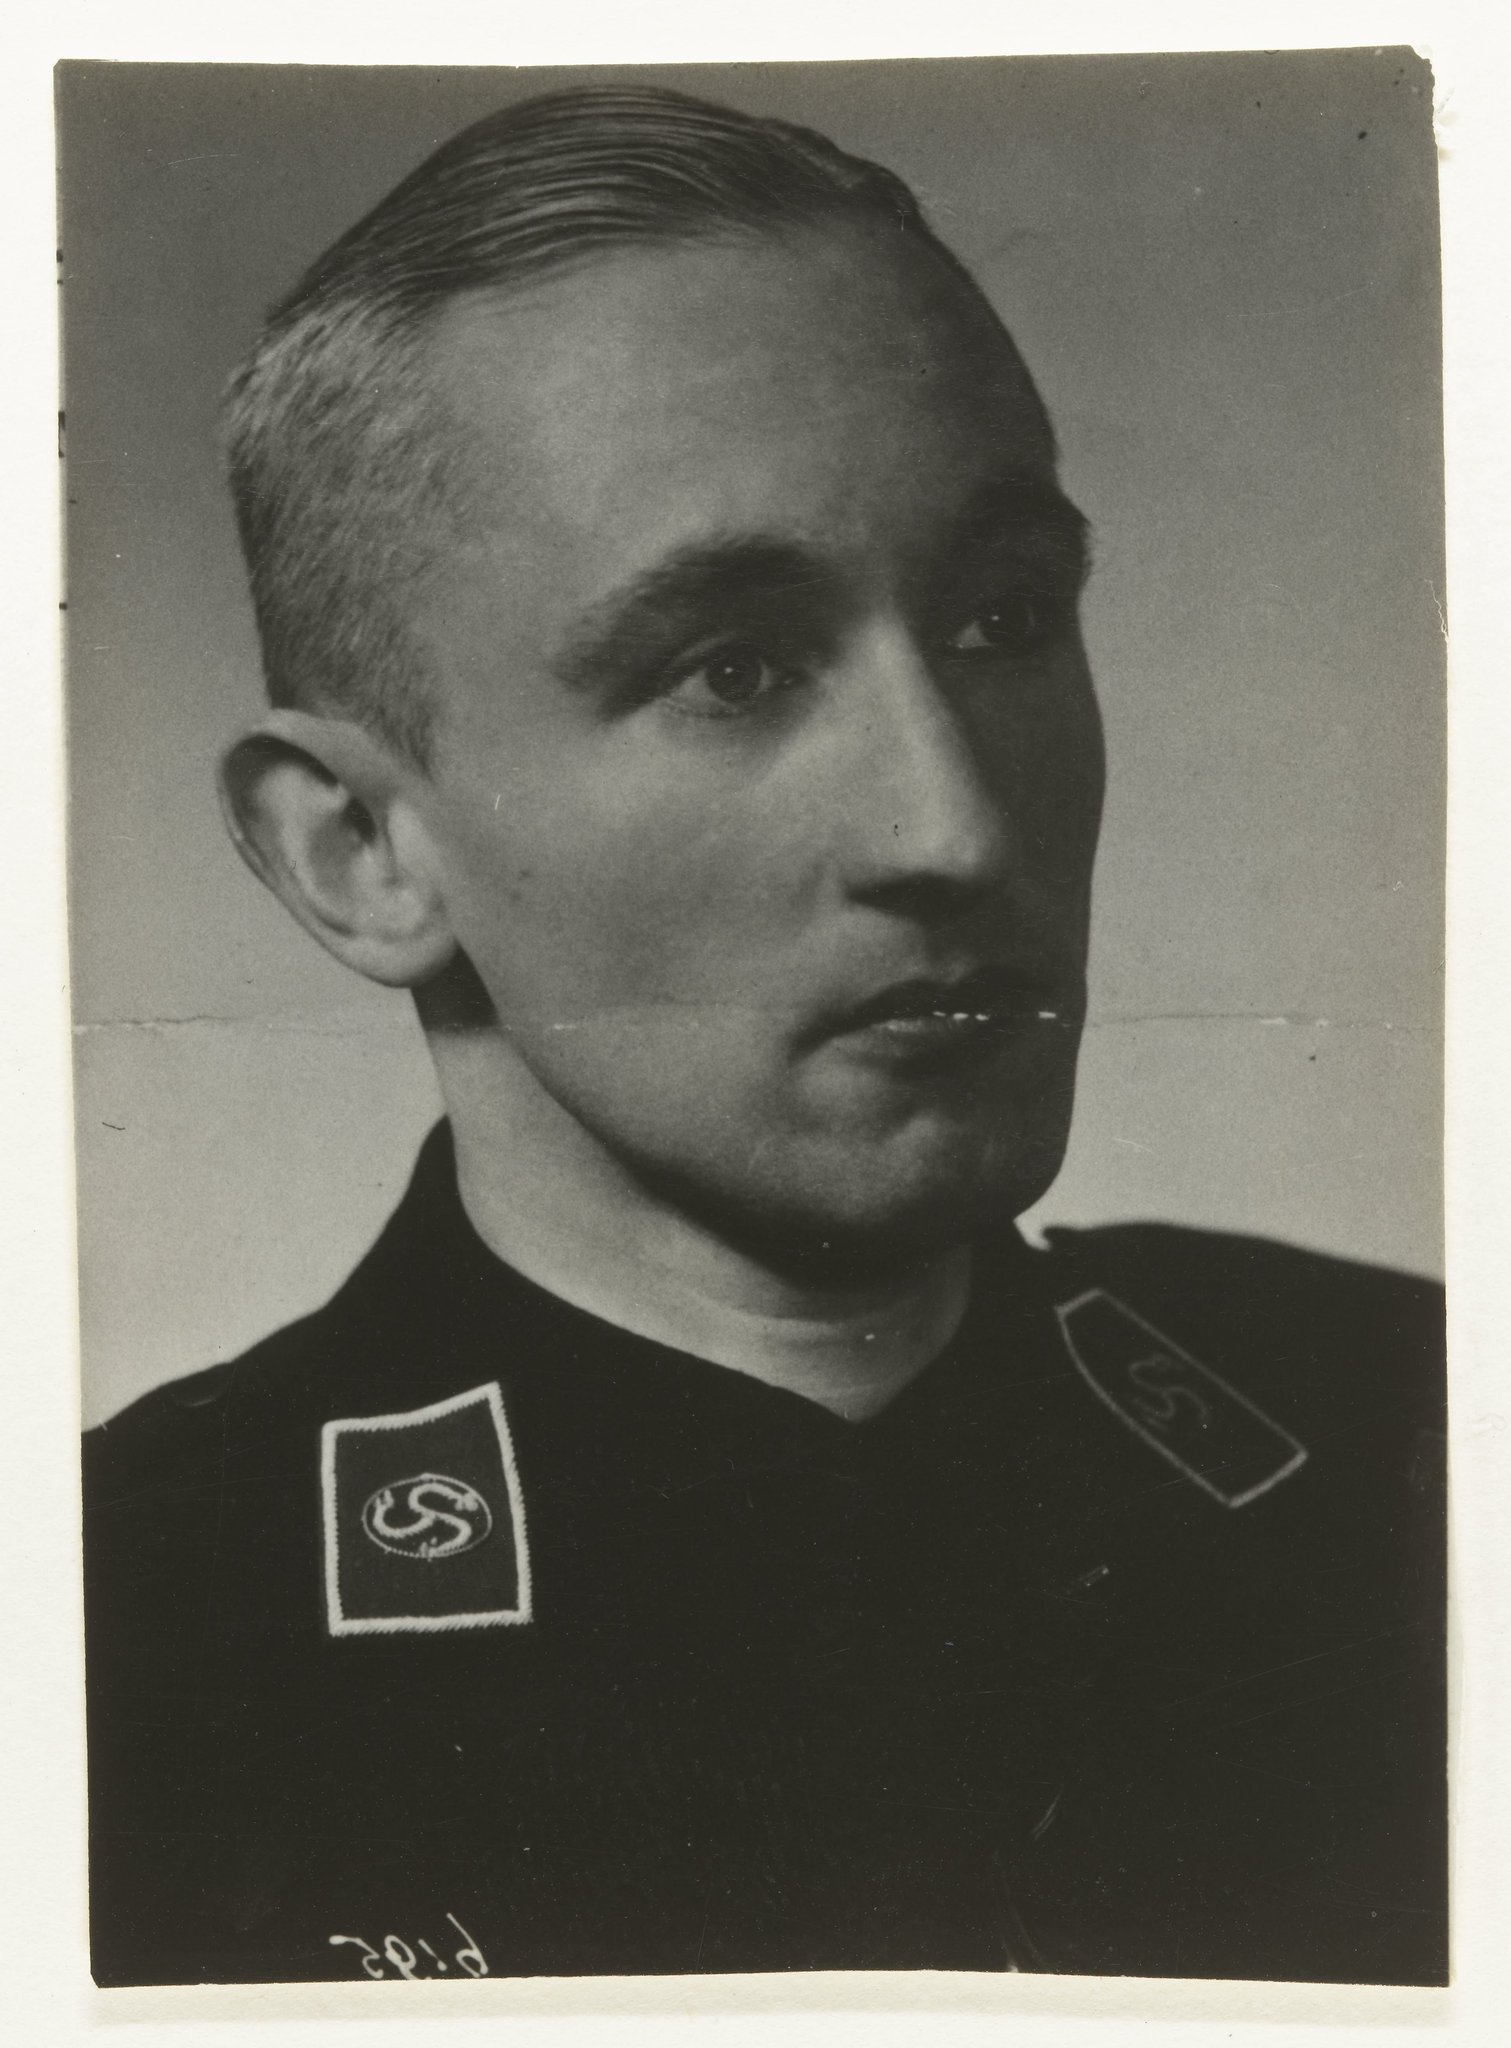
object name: contact print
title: Portret van een lid van de NSB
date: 1940-1944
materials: photographic support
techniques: photography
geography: netherlands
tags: anonymous historical person portrayed, netherlands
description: Portret van een lid van de NSB J.H. Groeneveld, Afd. A. van Administratie (zie achterzijde foto). Op zijn kraag een distinctief met een wentelend zonnerad: plaatsvervangend Sectieleider Fronten en Gilden. Blootshoofd. Kijkt naar links.